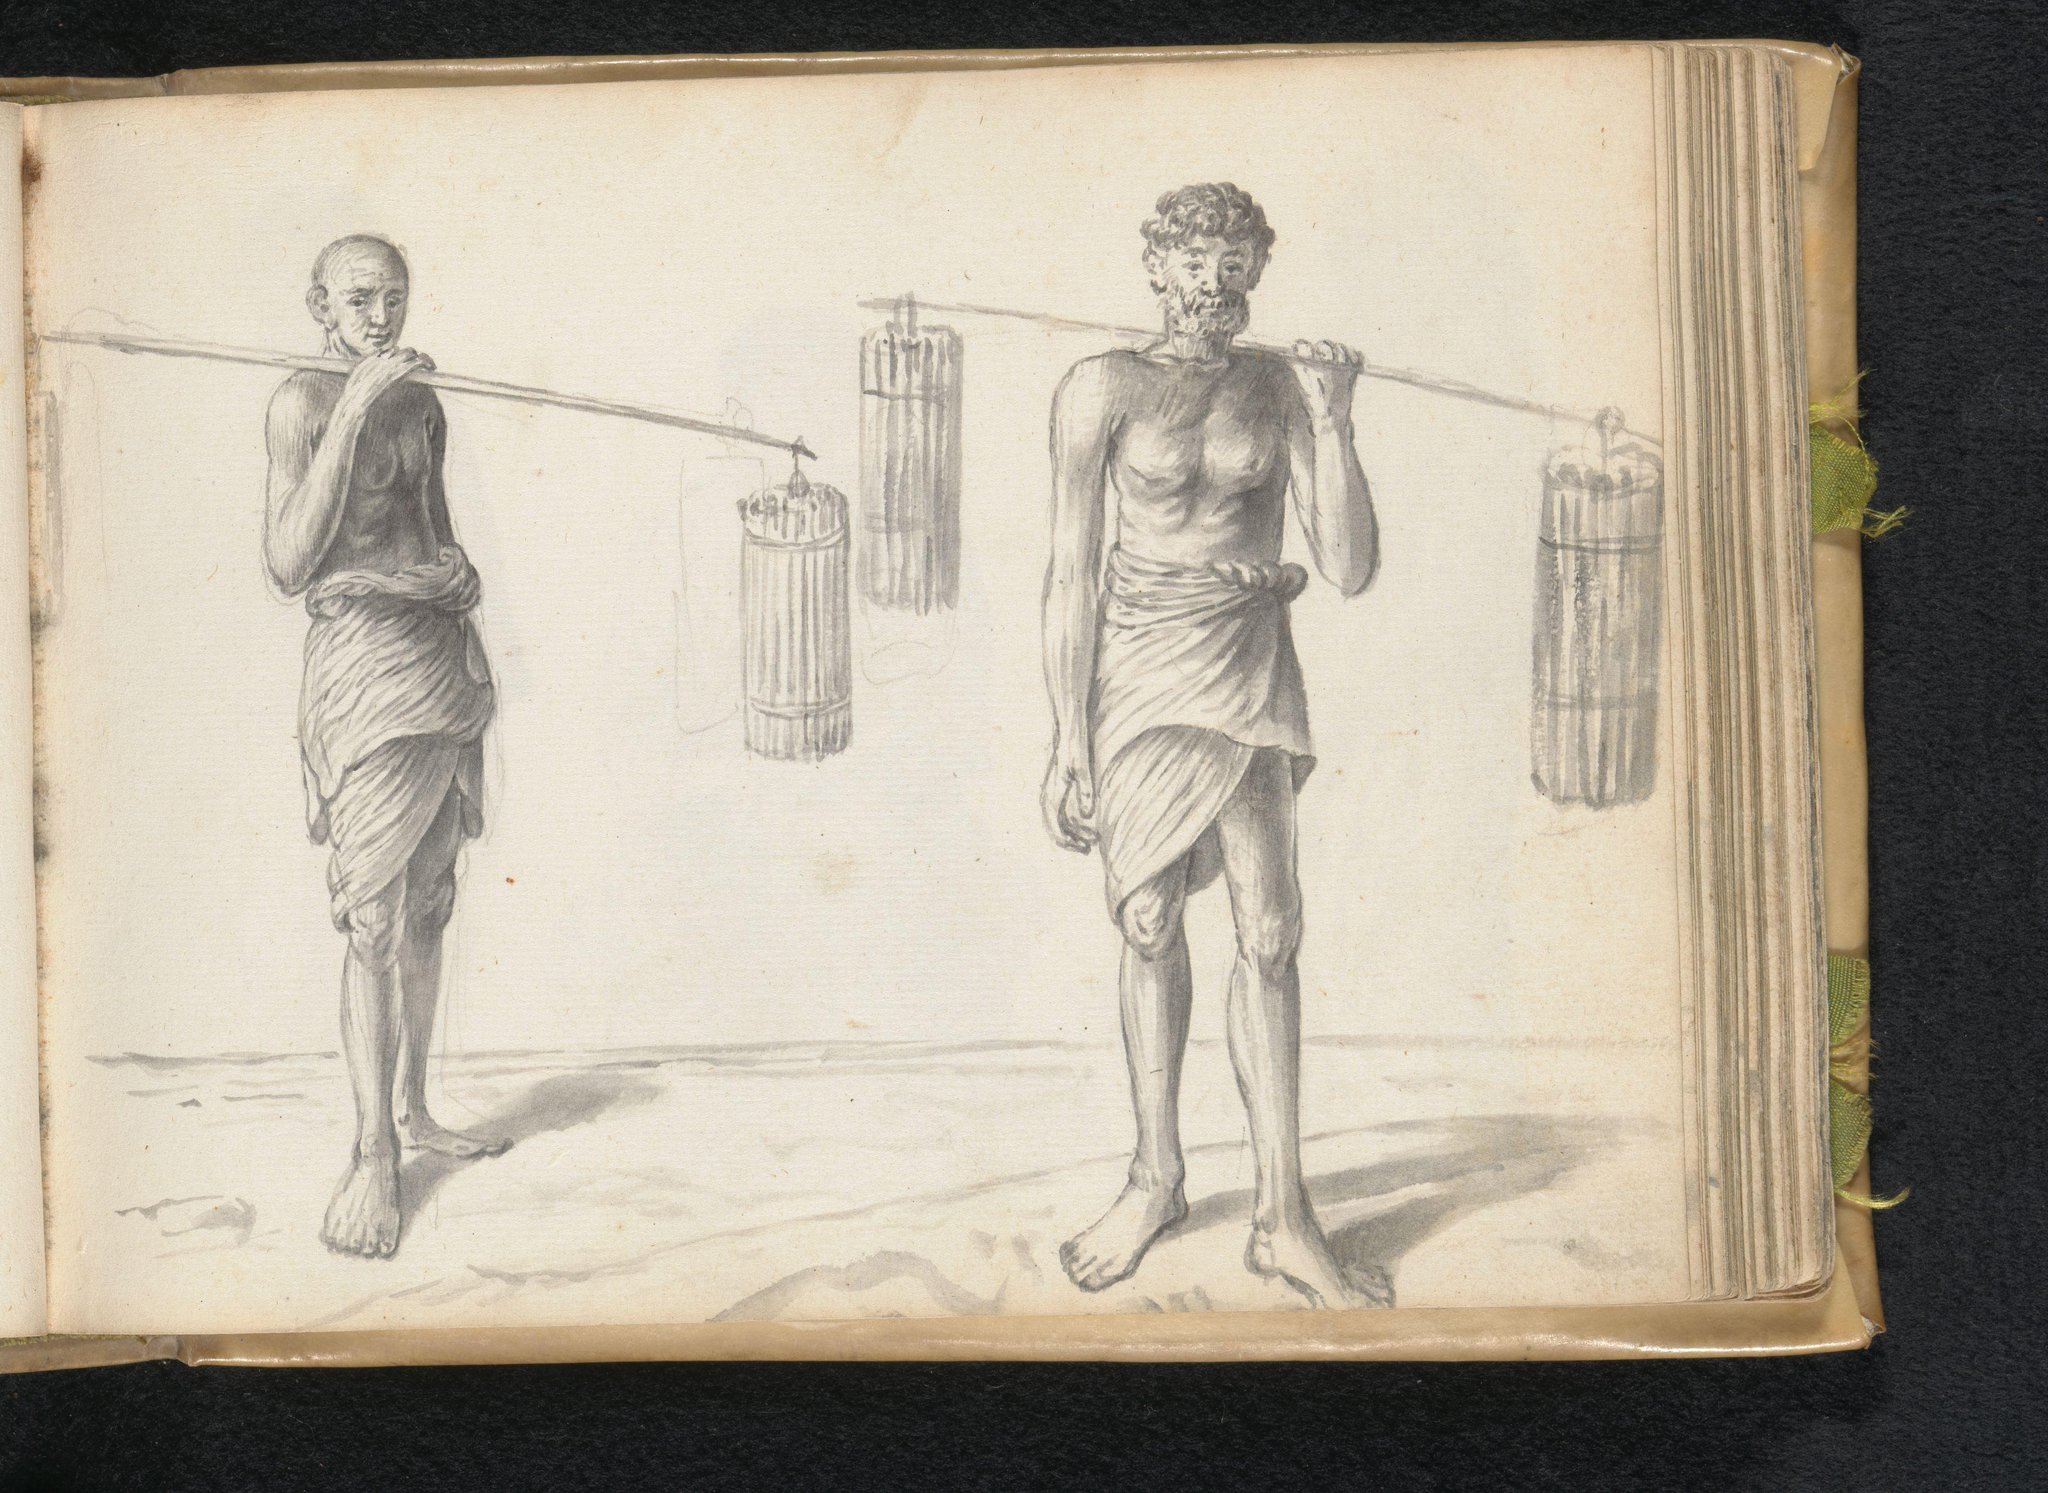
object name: sketchbook leaf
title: Two Sinhalese men with bales of cinnamon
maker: esaias boursse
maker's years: 1631-1672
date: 1662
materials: ink, paper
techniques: brush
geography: sri lanka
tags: (non-fruit) products of plants or trees: cinnamon, asiatic races and peoples (with name), 41d232(...) skirt (lungi), carrying something with yoke, sri lanka